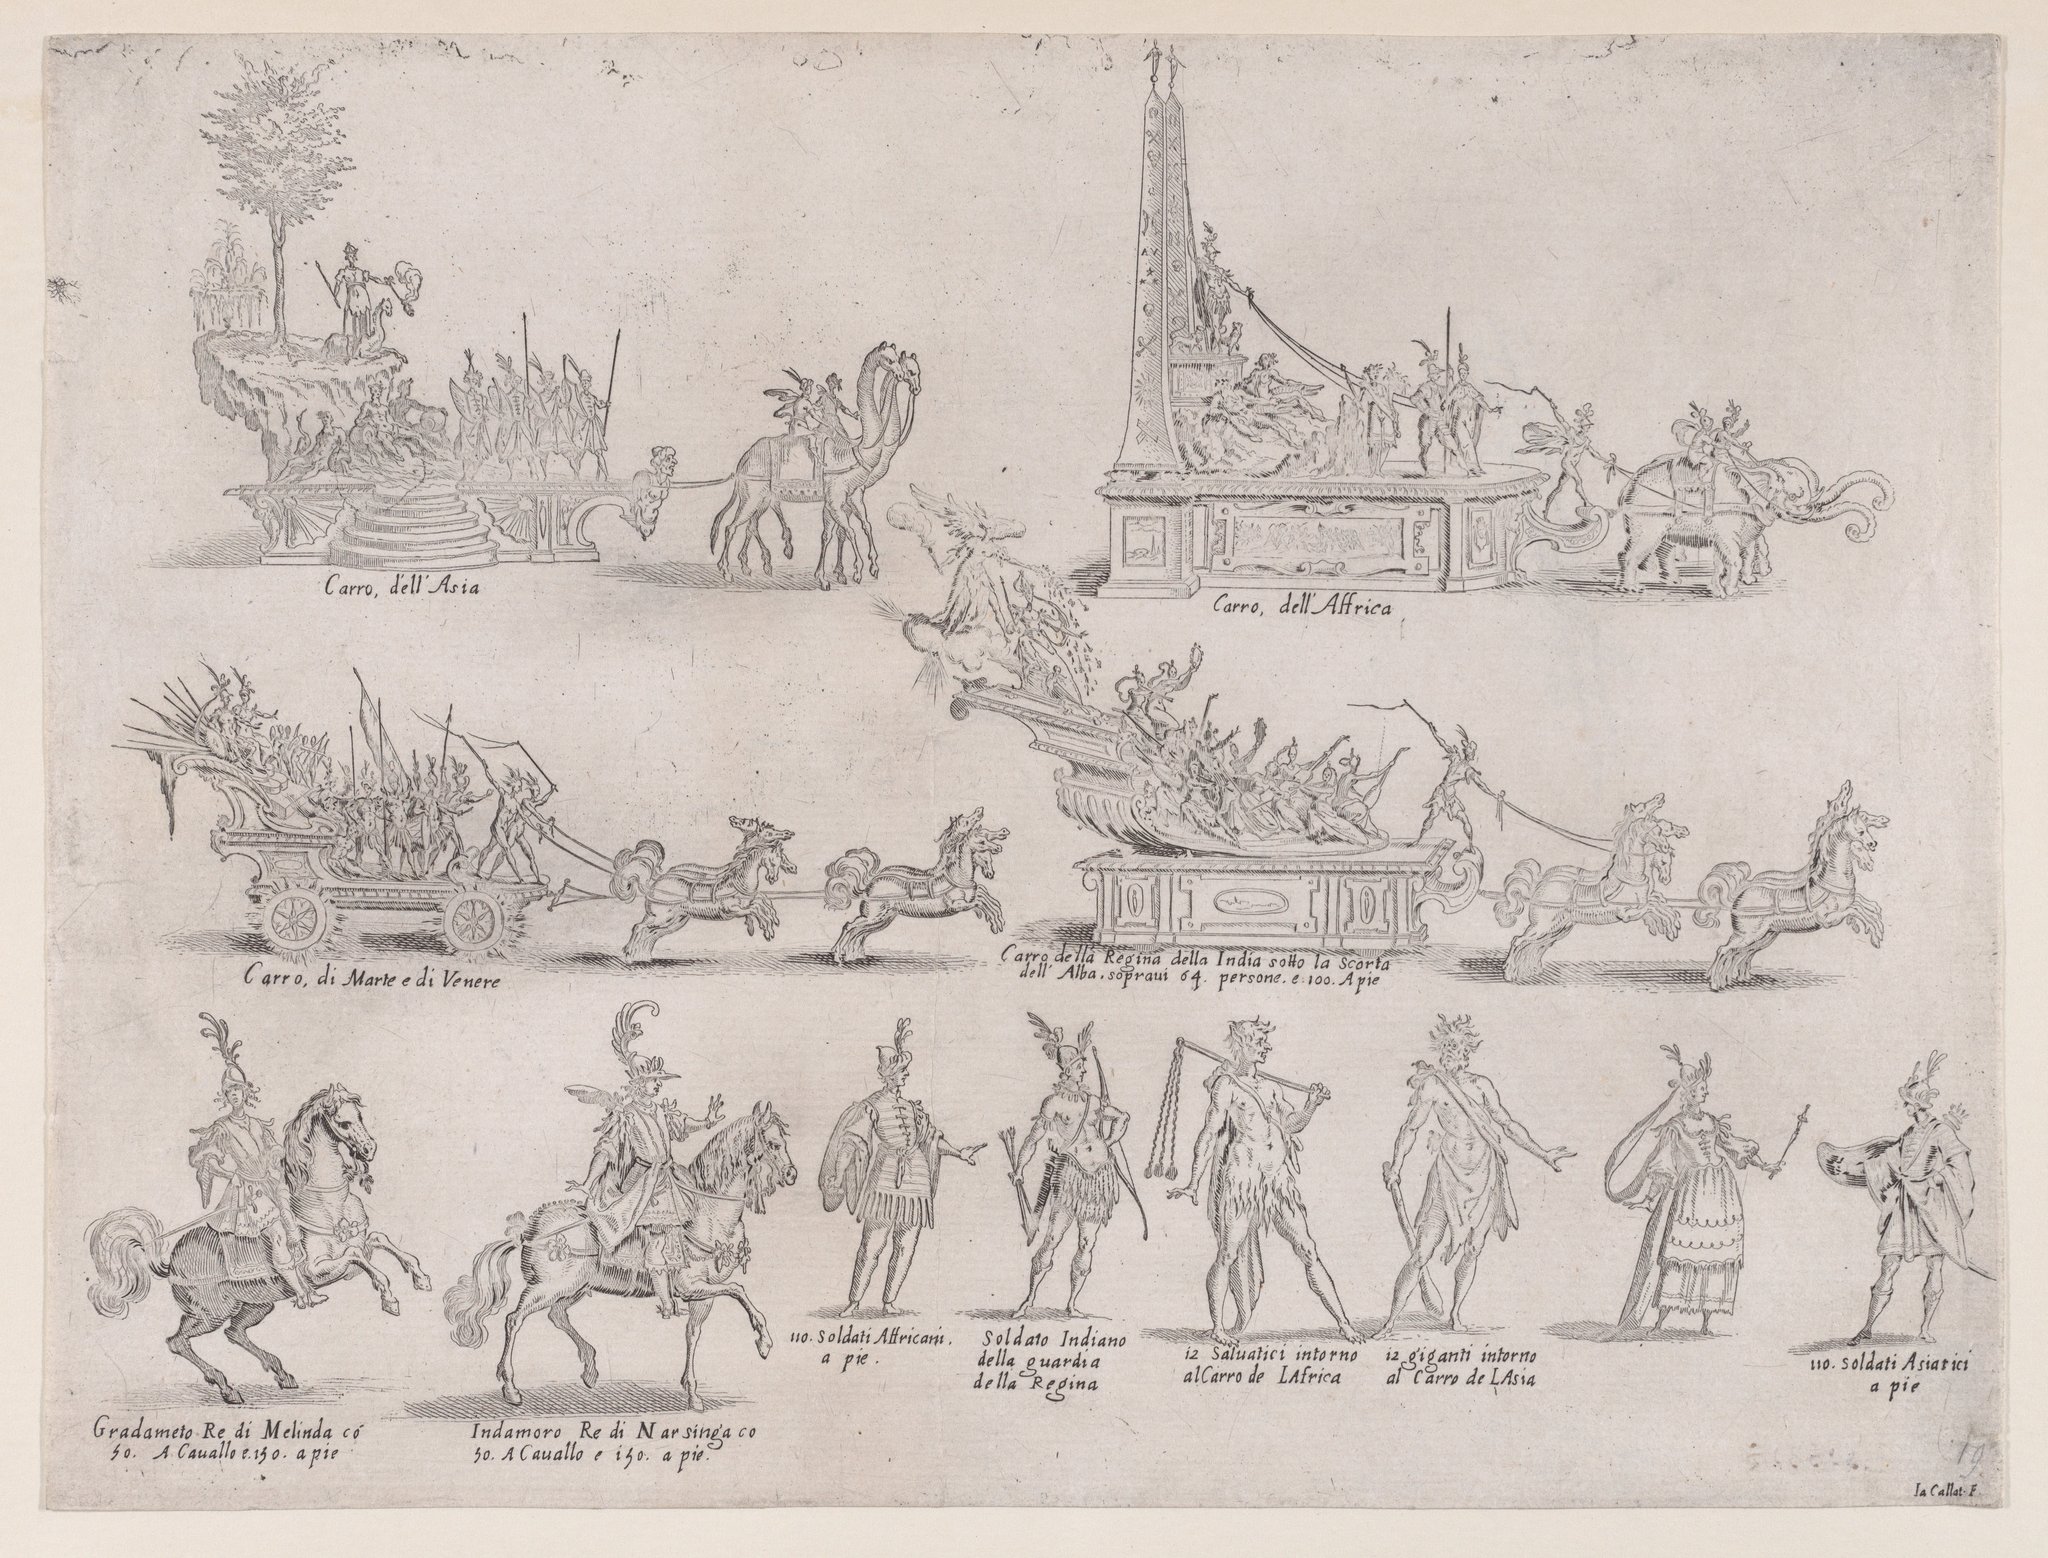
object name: print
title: Le Chars et Les Personnages (The Chariots and The Characters), from "La Guerre d'Amour" (Guerra d'Amore) (War of Love)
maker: jacques callot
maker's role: artist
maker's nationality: french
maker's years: 1592-1635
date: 1615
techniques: etching